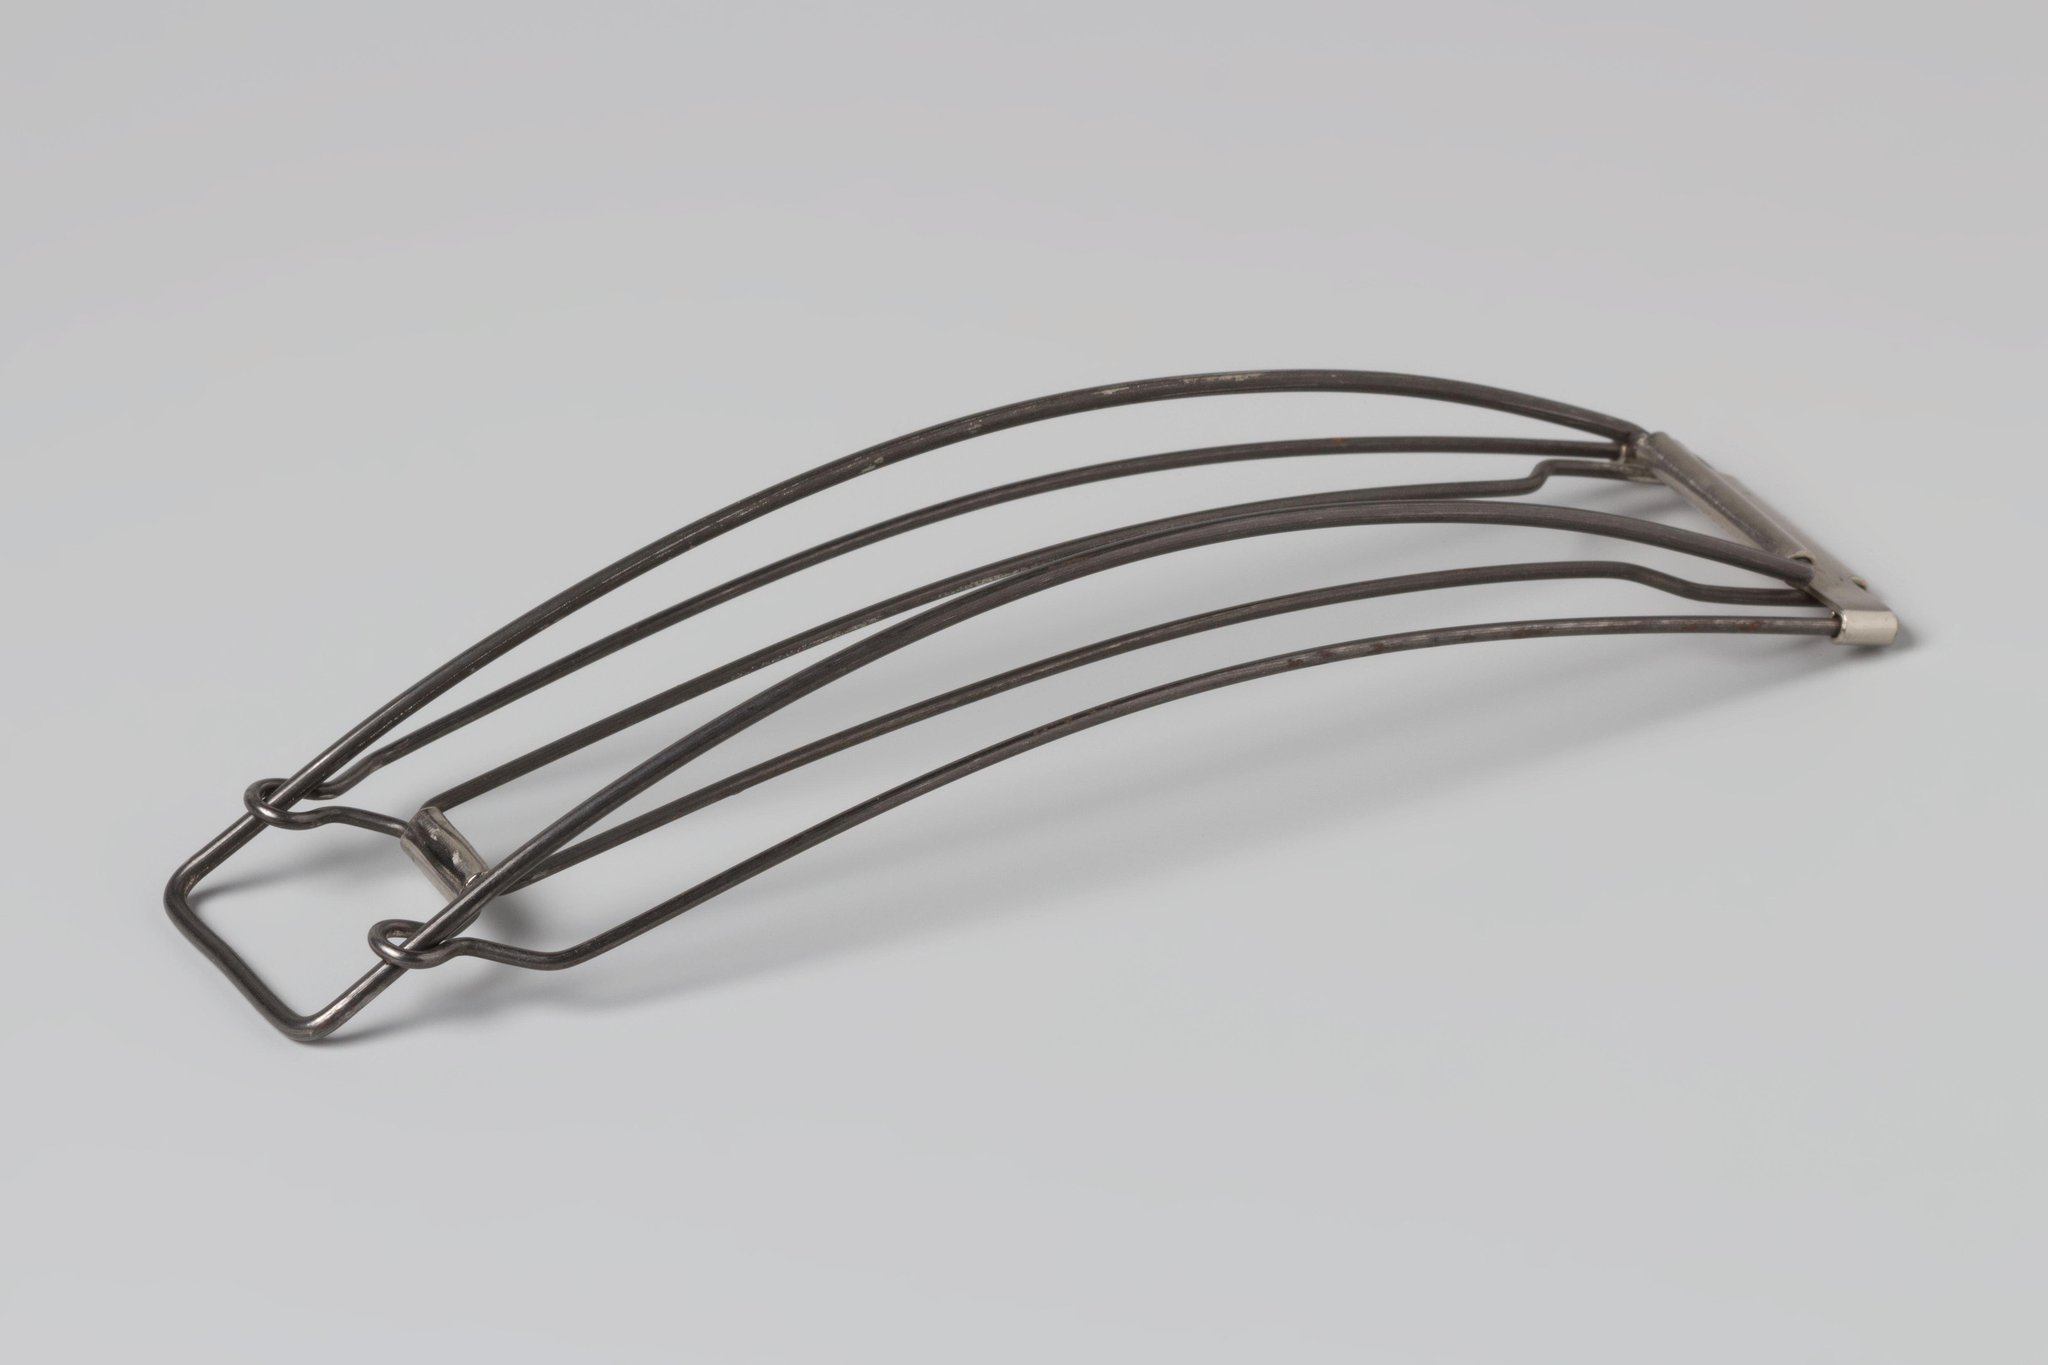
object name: womenswear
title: Onduleerijzer (?) van staal, rechthoekig, in de vorm van een gesp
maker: Anonymous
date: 1925-1930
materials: steel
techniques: forging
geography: netherlands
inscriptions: number: ‘'PAT No 1719928'’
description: Onduleerijzer (?) of gesp van staal, rechthoekig, in de vorm van een gesp. Voorzien van patentnummer: 'PAT No 1719928'.